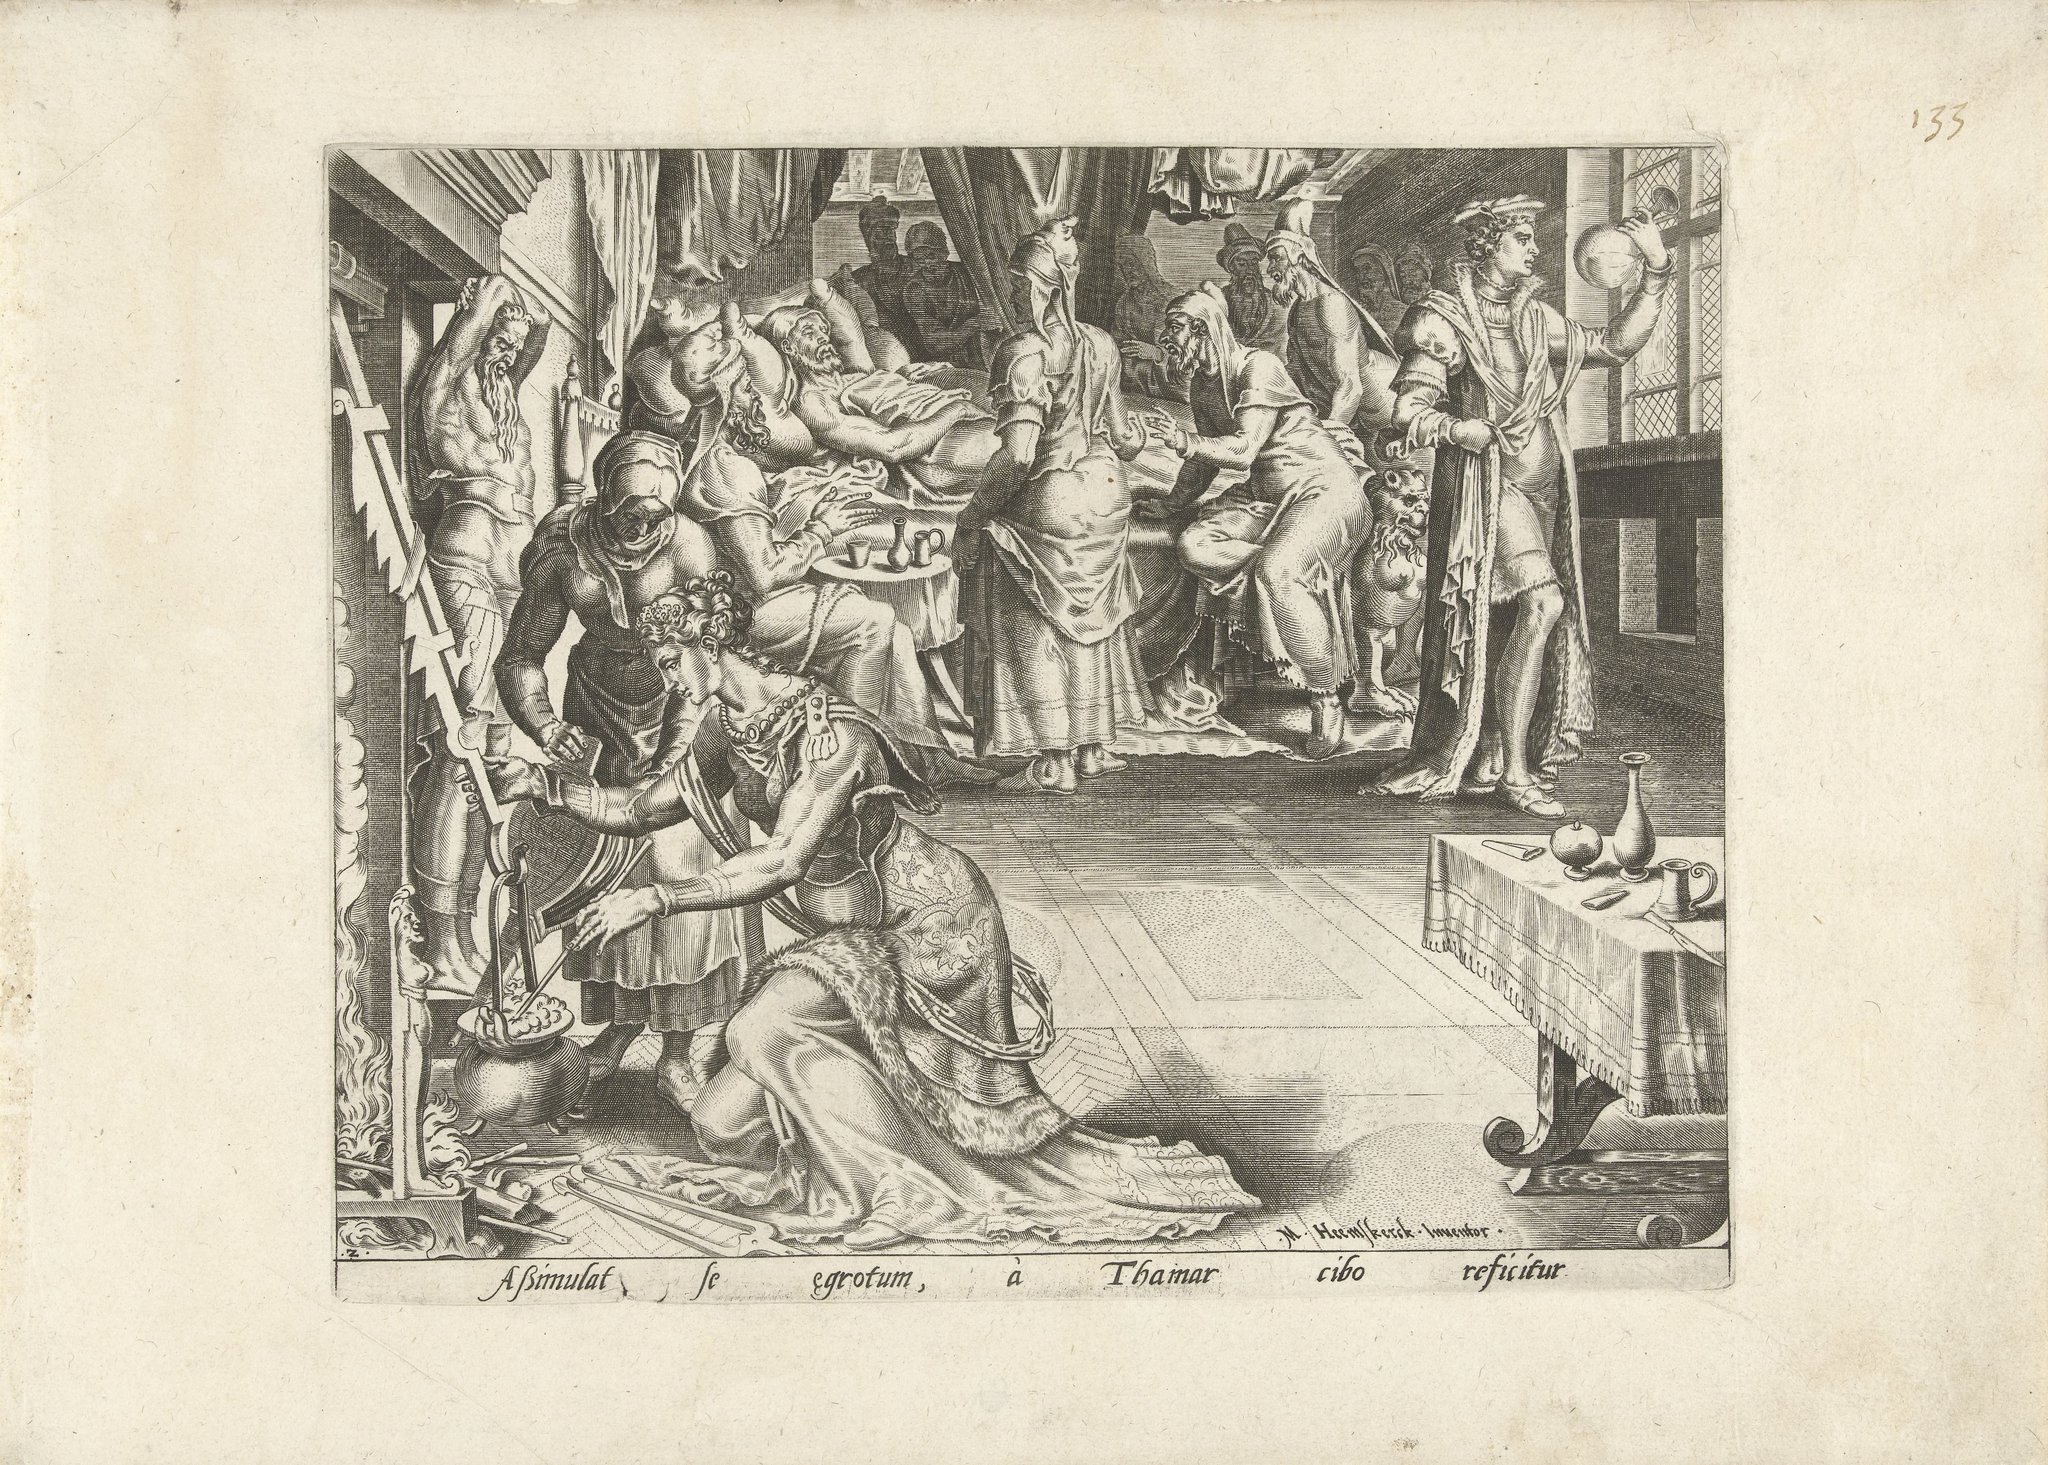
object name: print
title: Geschiedenis van Tamar en Amnon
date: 1559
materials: paper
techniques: engraving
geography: antwerp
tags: tamar preparing cakes for amnon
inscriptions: collector's mark: Lugt 2760, collector's mark: Lugt 2228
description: Tamar kookt voor haar zieke halfbroer Amnon die op bed ligt. Ze knielt voor een open haard en roert in een ketel. Op de achtergrond ligt Amnon op bed omgeven door een groep van mannen. Een piskijker staat bij het raam en bekijkt een kruik met urine.